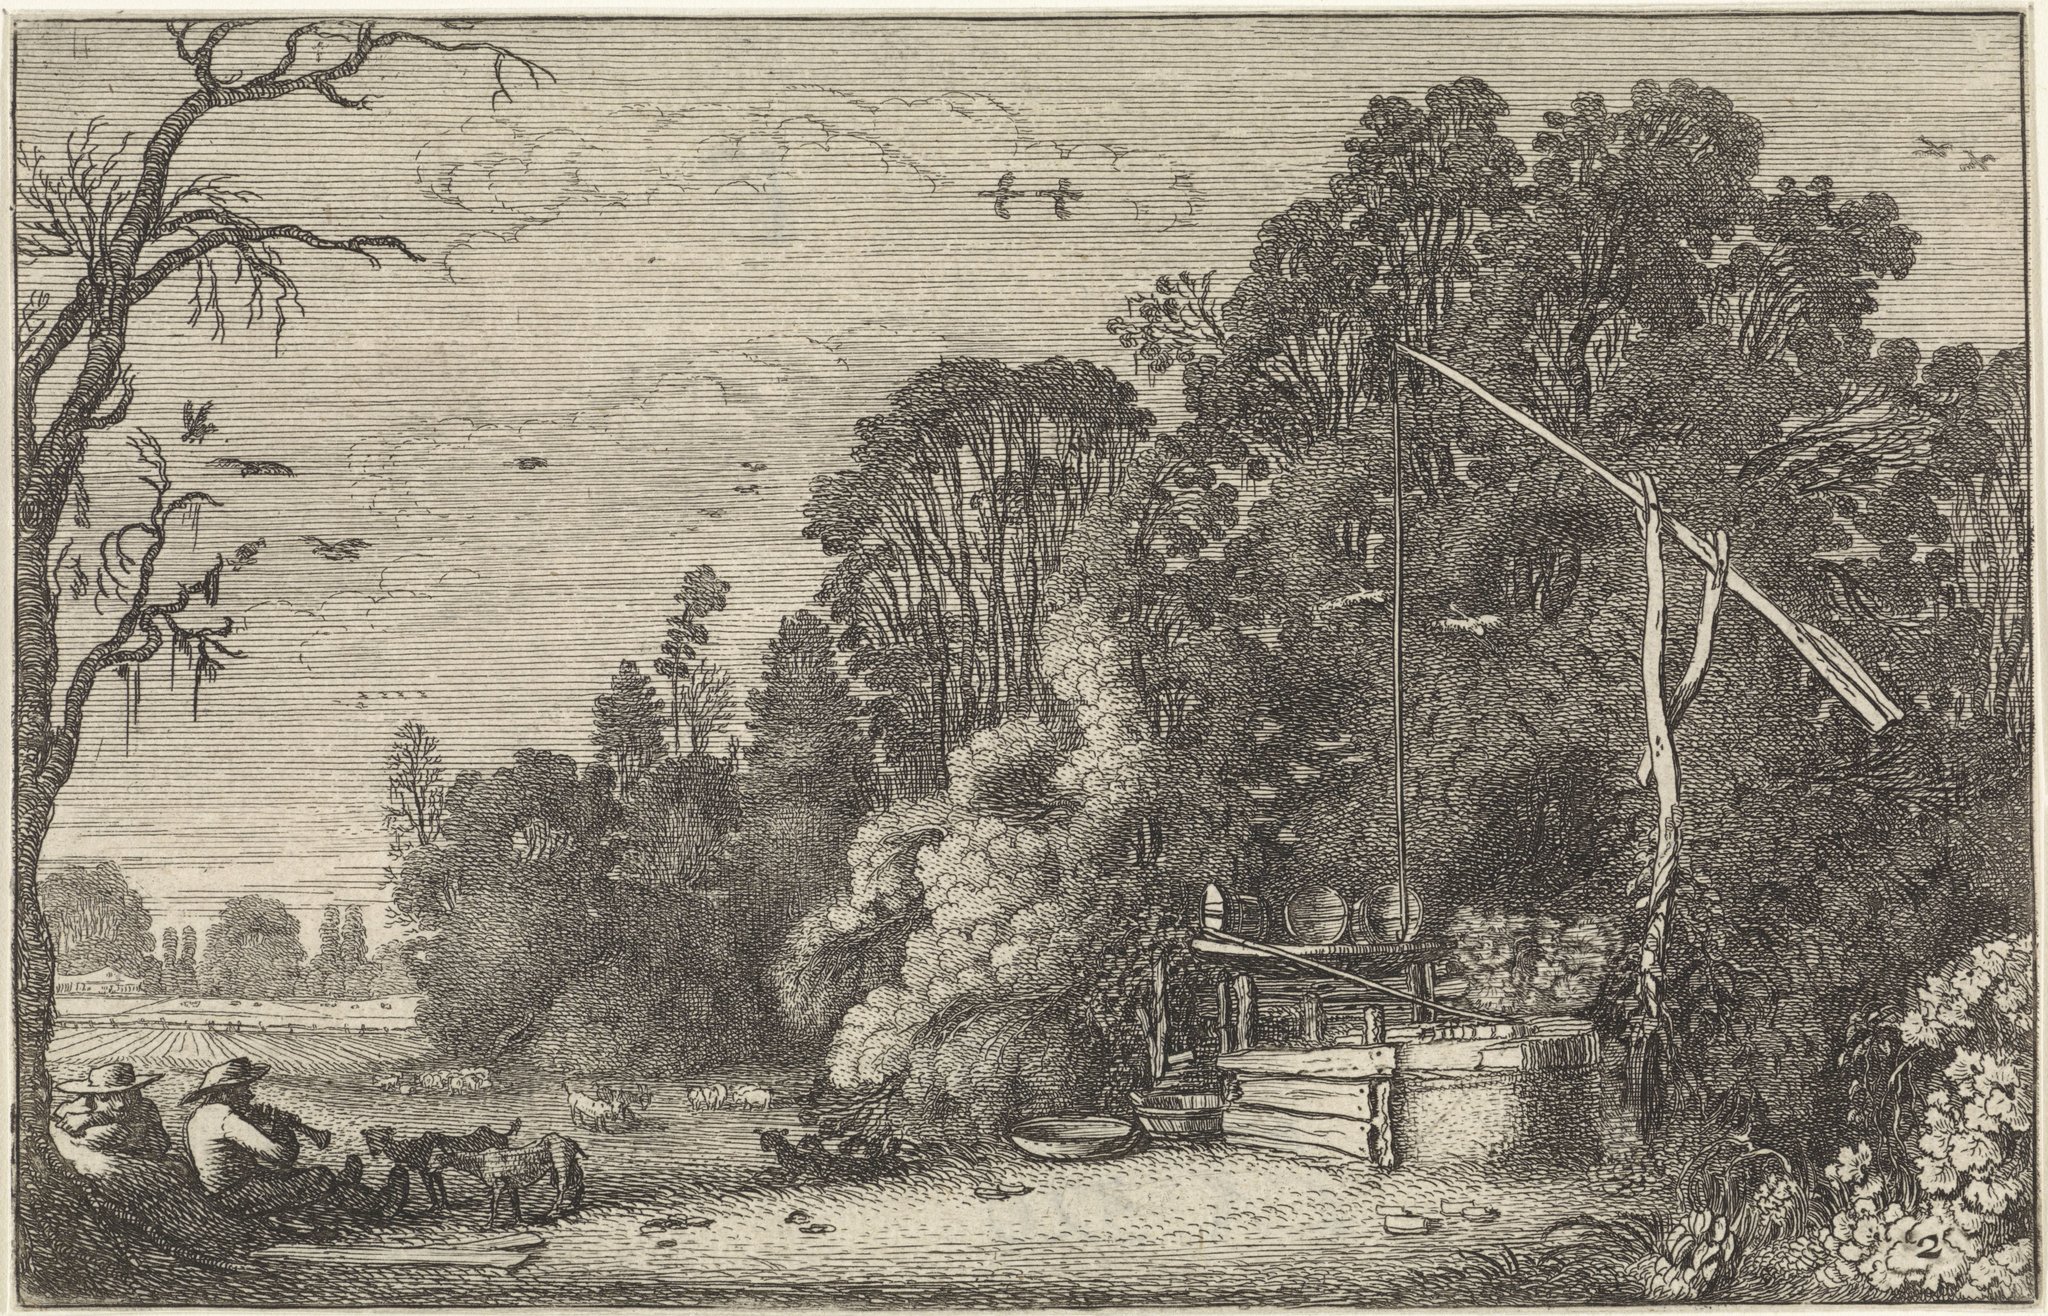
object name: print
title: Boomlandschap met een waterput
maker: jan van de velde (ii)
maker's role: draughtsman, painter, print maker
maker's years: 1593-1641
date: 1616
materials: paper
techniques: etching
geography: northern netherlands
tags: well, trees, herding, herdsman, herdswoman, shepherd, shepherdess, cowherd, etc., flute, aulos, tibia - cc - out of doors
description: Zittende fluitspelende herder bij een kudde in een landschap. Naast hem een tweede figuur. Voor een bomenrij een waterput. Tweede prent van deel vijf van een serie van in totaal zestig prenten met landschappen, verdeeld over vijf delen van elk twaalf prenten.